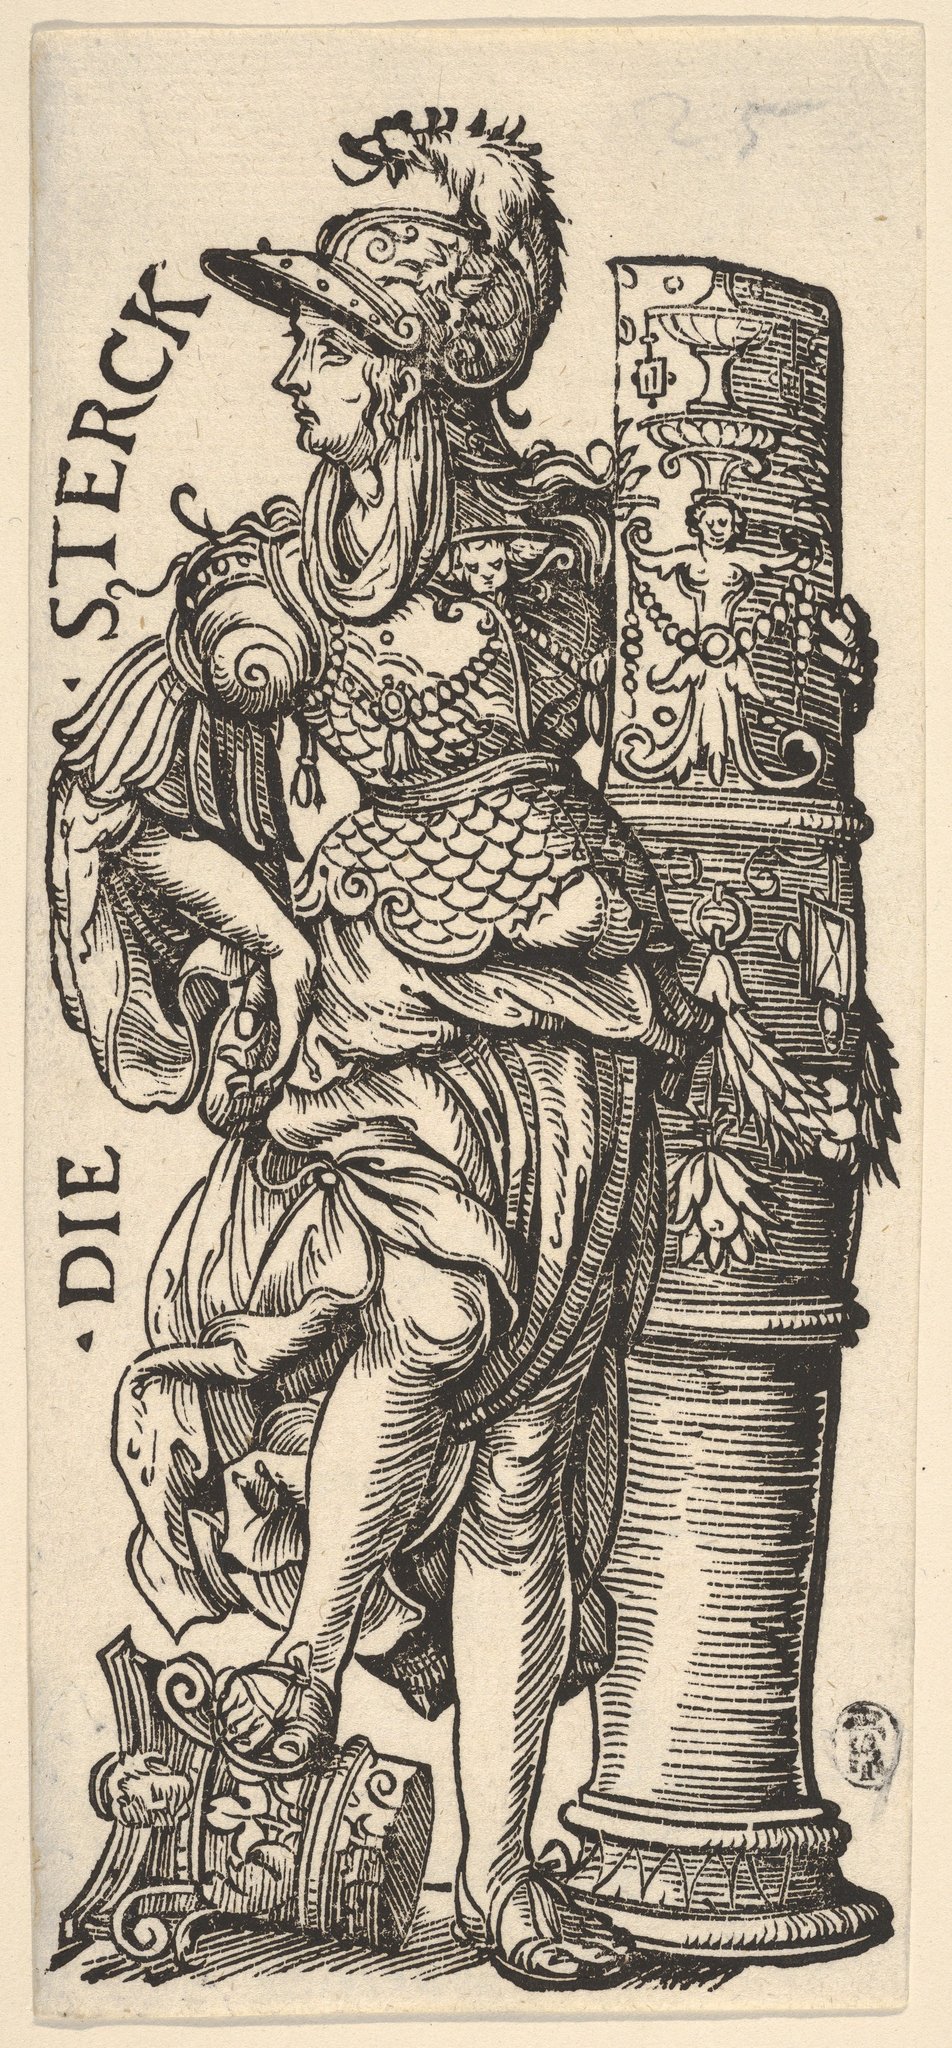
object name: print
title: Fortitude (Die Sterck), from "The Seven Virtues"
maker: hans burgkmair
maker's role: artist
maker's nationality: german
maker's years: 1473-1531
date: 1498-1531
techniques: woodcut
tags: profiles,women